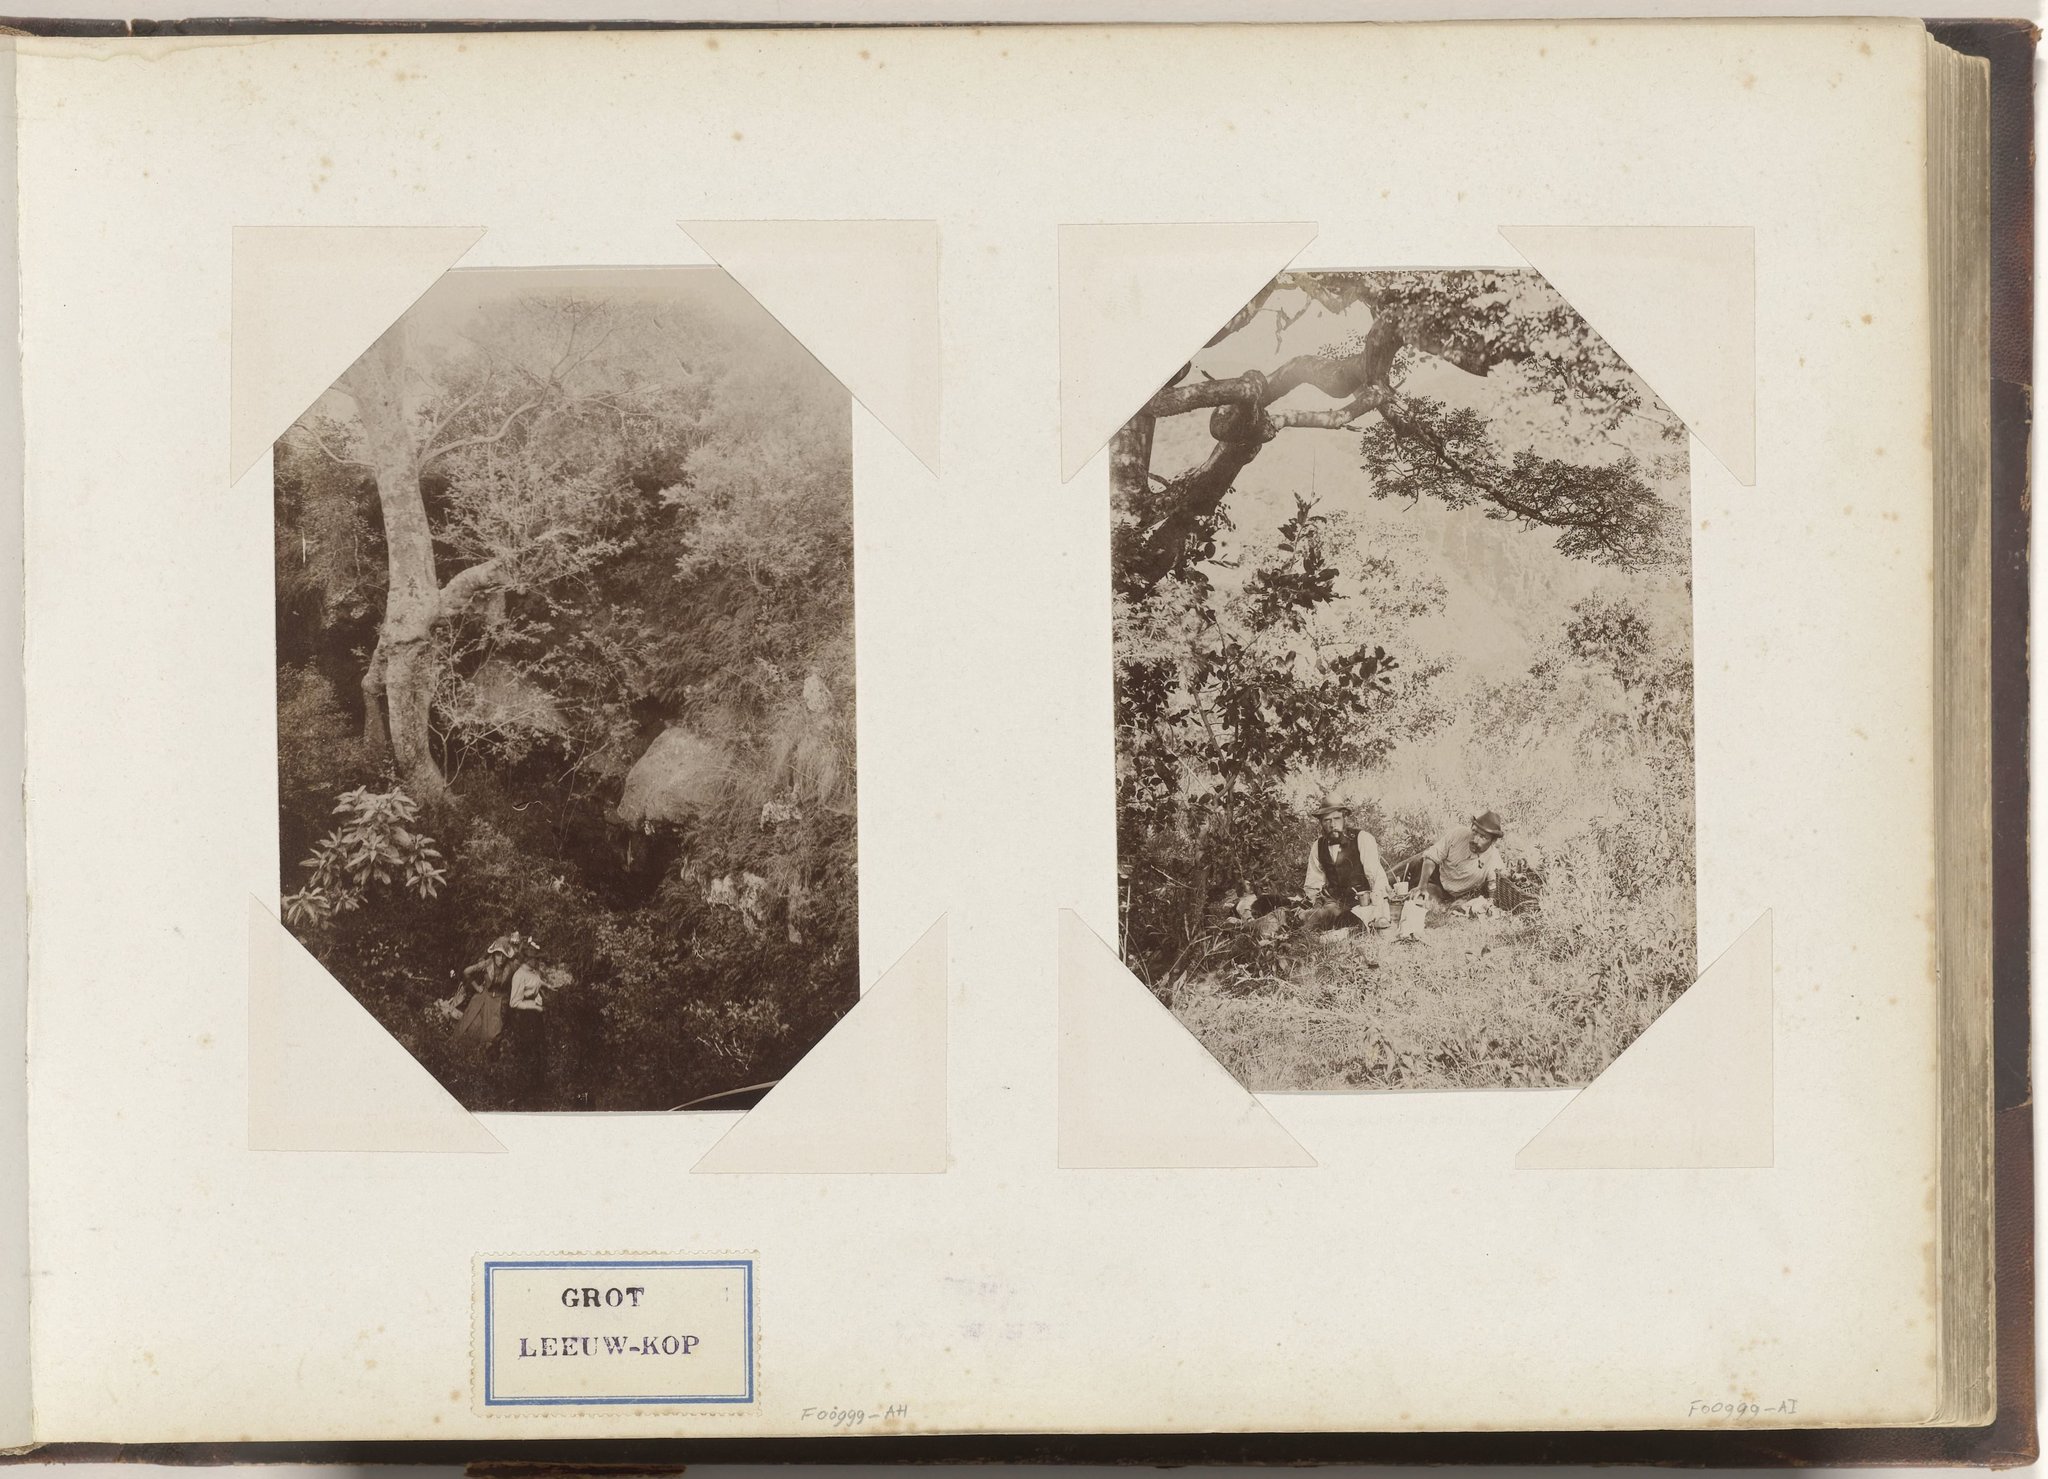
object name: photograph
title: Twee mannen houden een picknick onder een boom, vermoedelijk in Zuid-Afrika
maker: Anonymous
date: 1885-1910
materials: paper, photographic support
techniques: daylight paper print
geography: south africa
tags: eating and drinking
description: Onderdeel van Album met 191 foto's van een reis naar en door Zuid-Afrika.